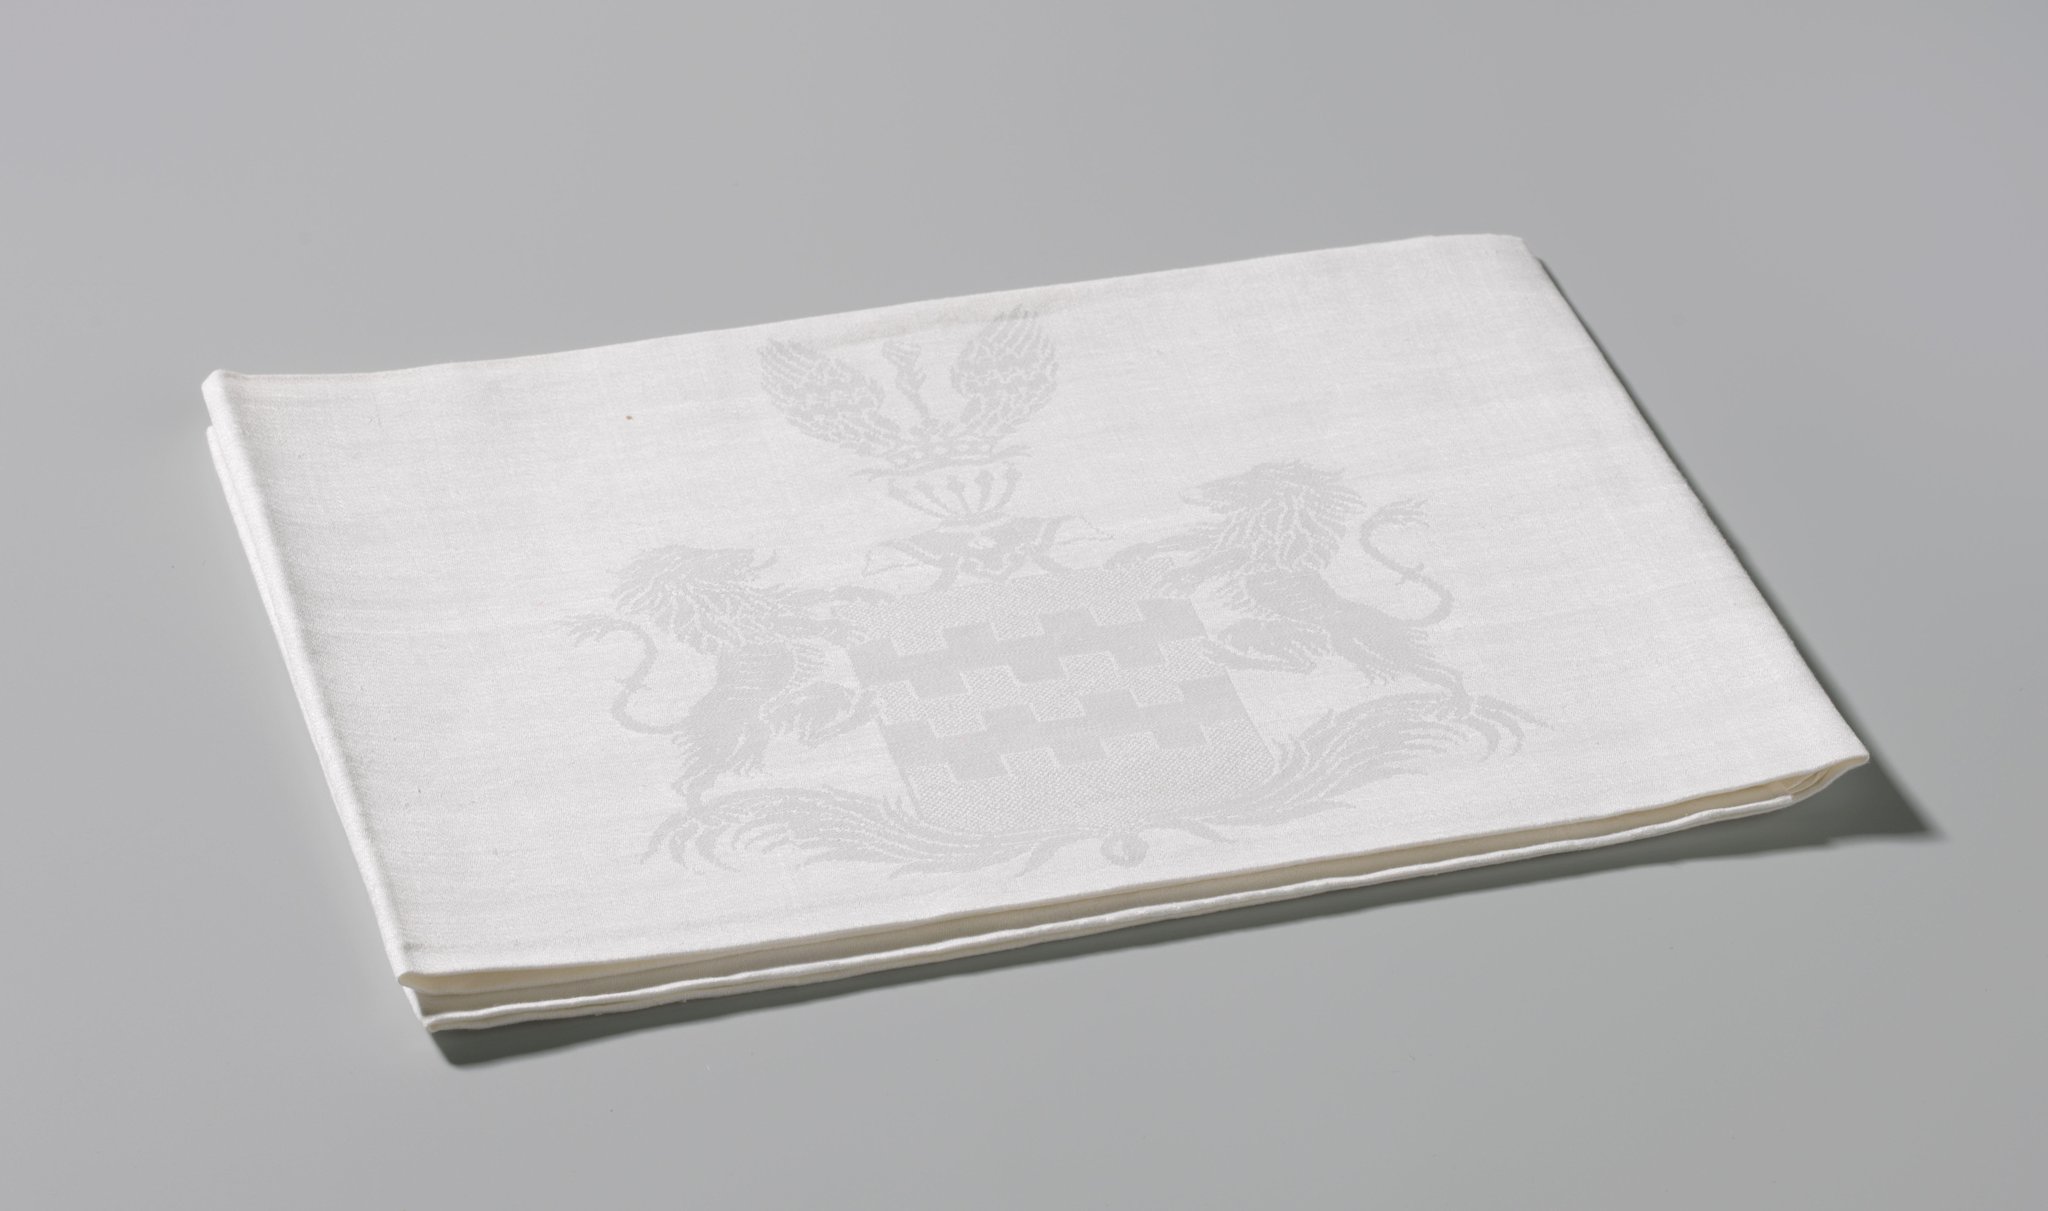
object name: napkin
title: Servet van wit linnendamast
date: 1874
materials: linen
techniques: damask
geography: north brabant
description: Wit linnen damasten servet met voluten en het wapen Van Boelens van der Haer.